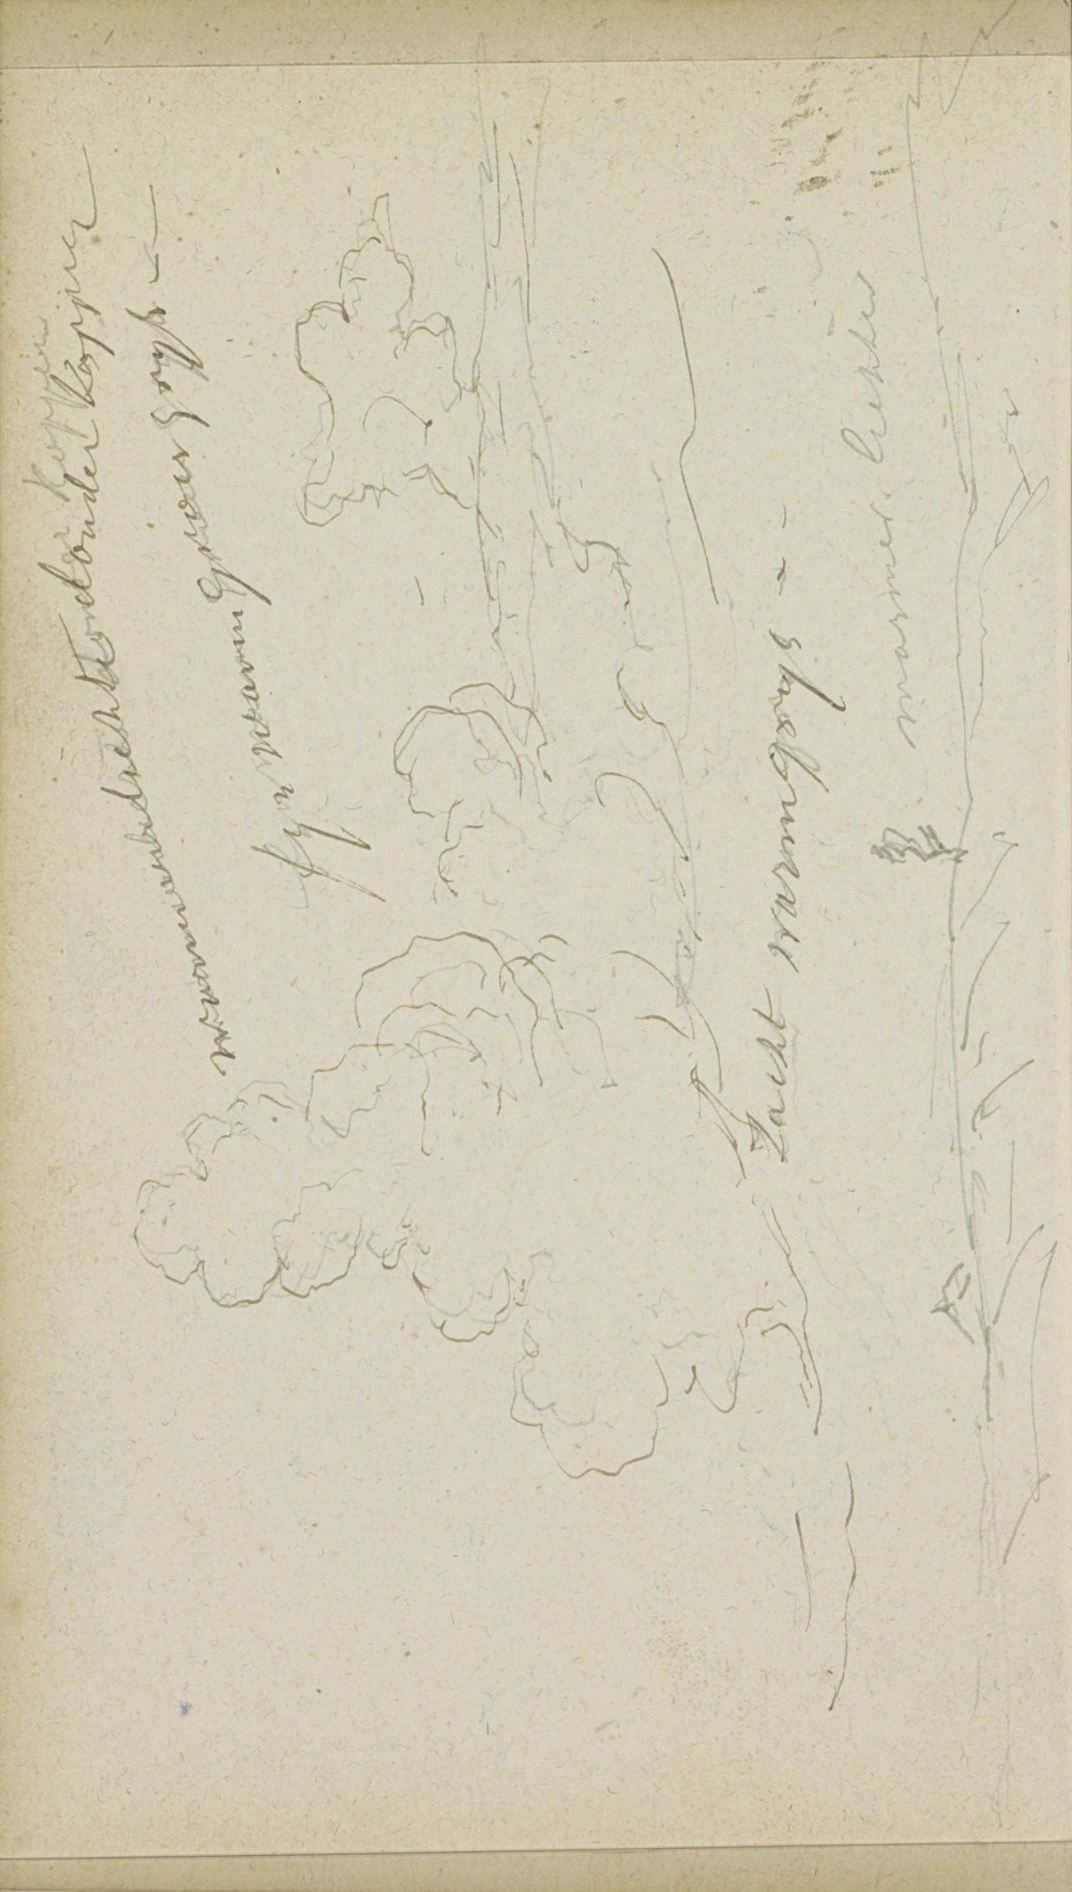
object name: sketchbook leaf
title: Wolken met donderkoppen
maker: johannes tavenraat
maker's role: draughtsman, painter, print maker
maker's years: 1809-1881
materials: ink, paper, pencil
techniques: pen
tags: clouds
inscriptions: kleurnotitie, handgeschreven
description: Blad 31 verso uit een schetsboek met 88 bladen.